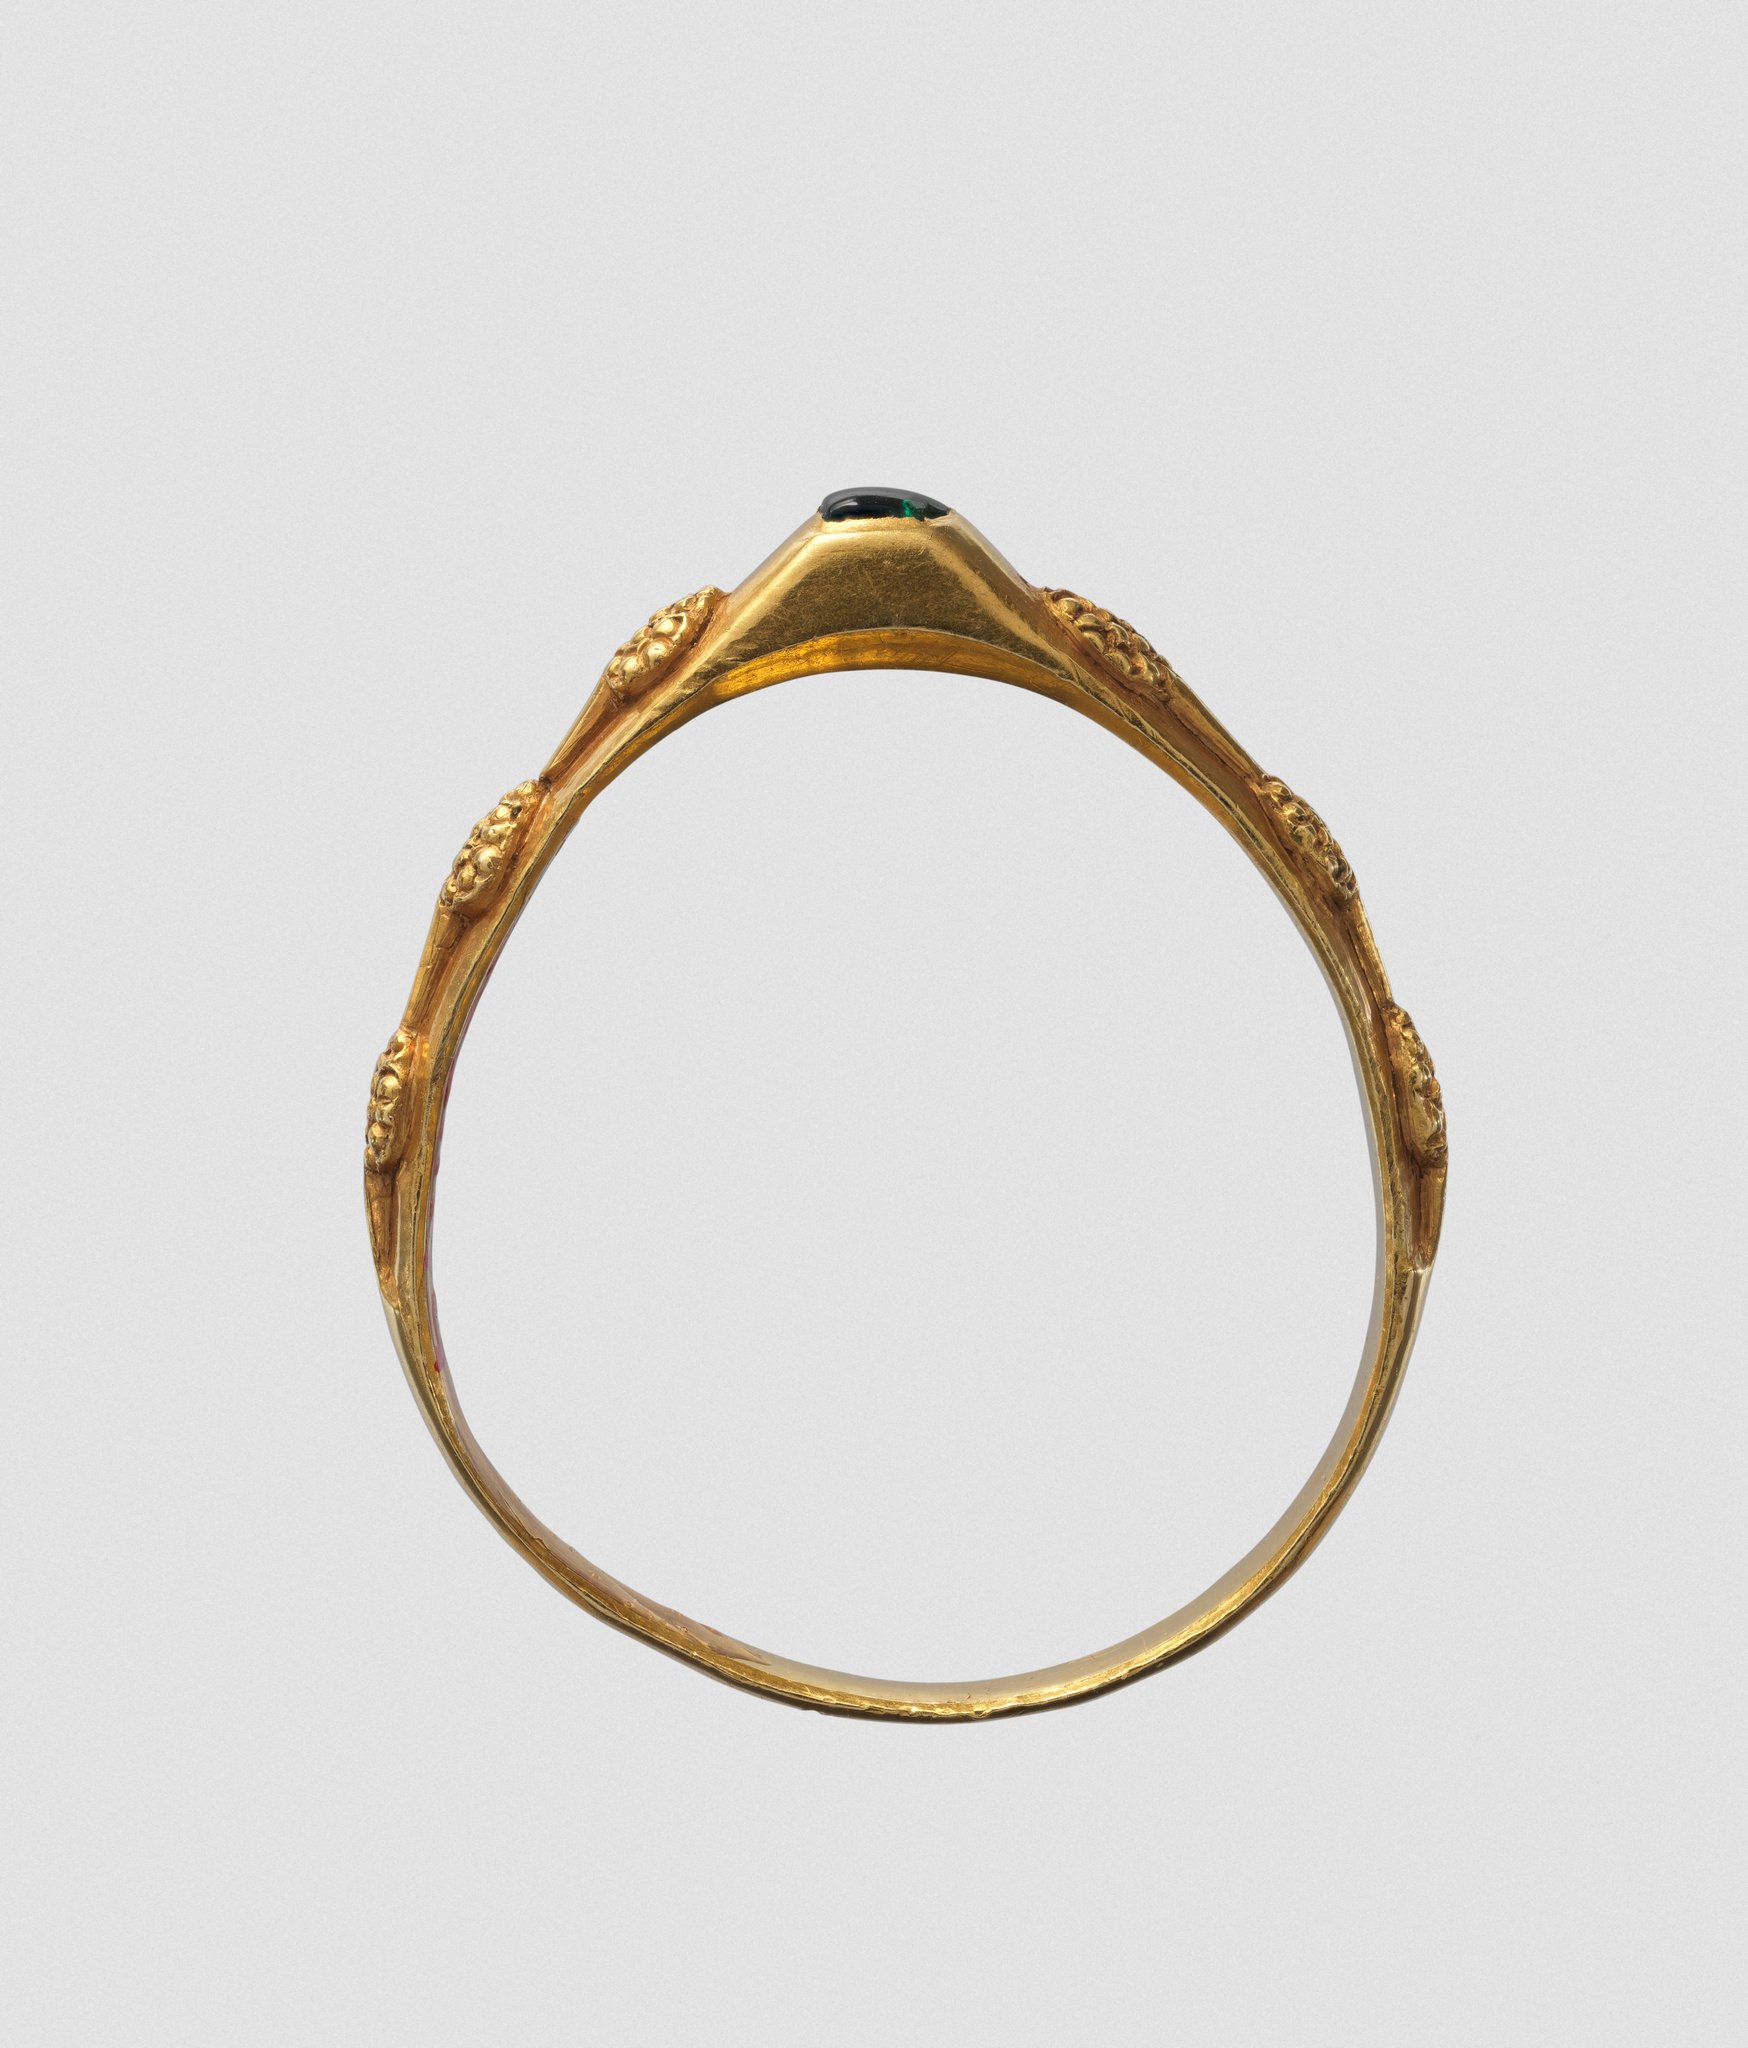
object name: ring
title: Stirrup Ring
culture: british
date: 1200-1300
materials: gemstone, gold